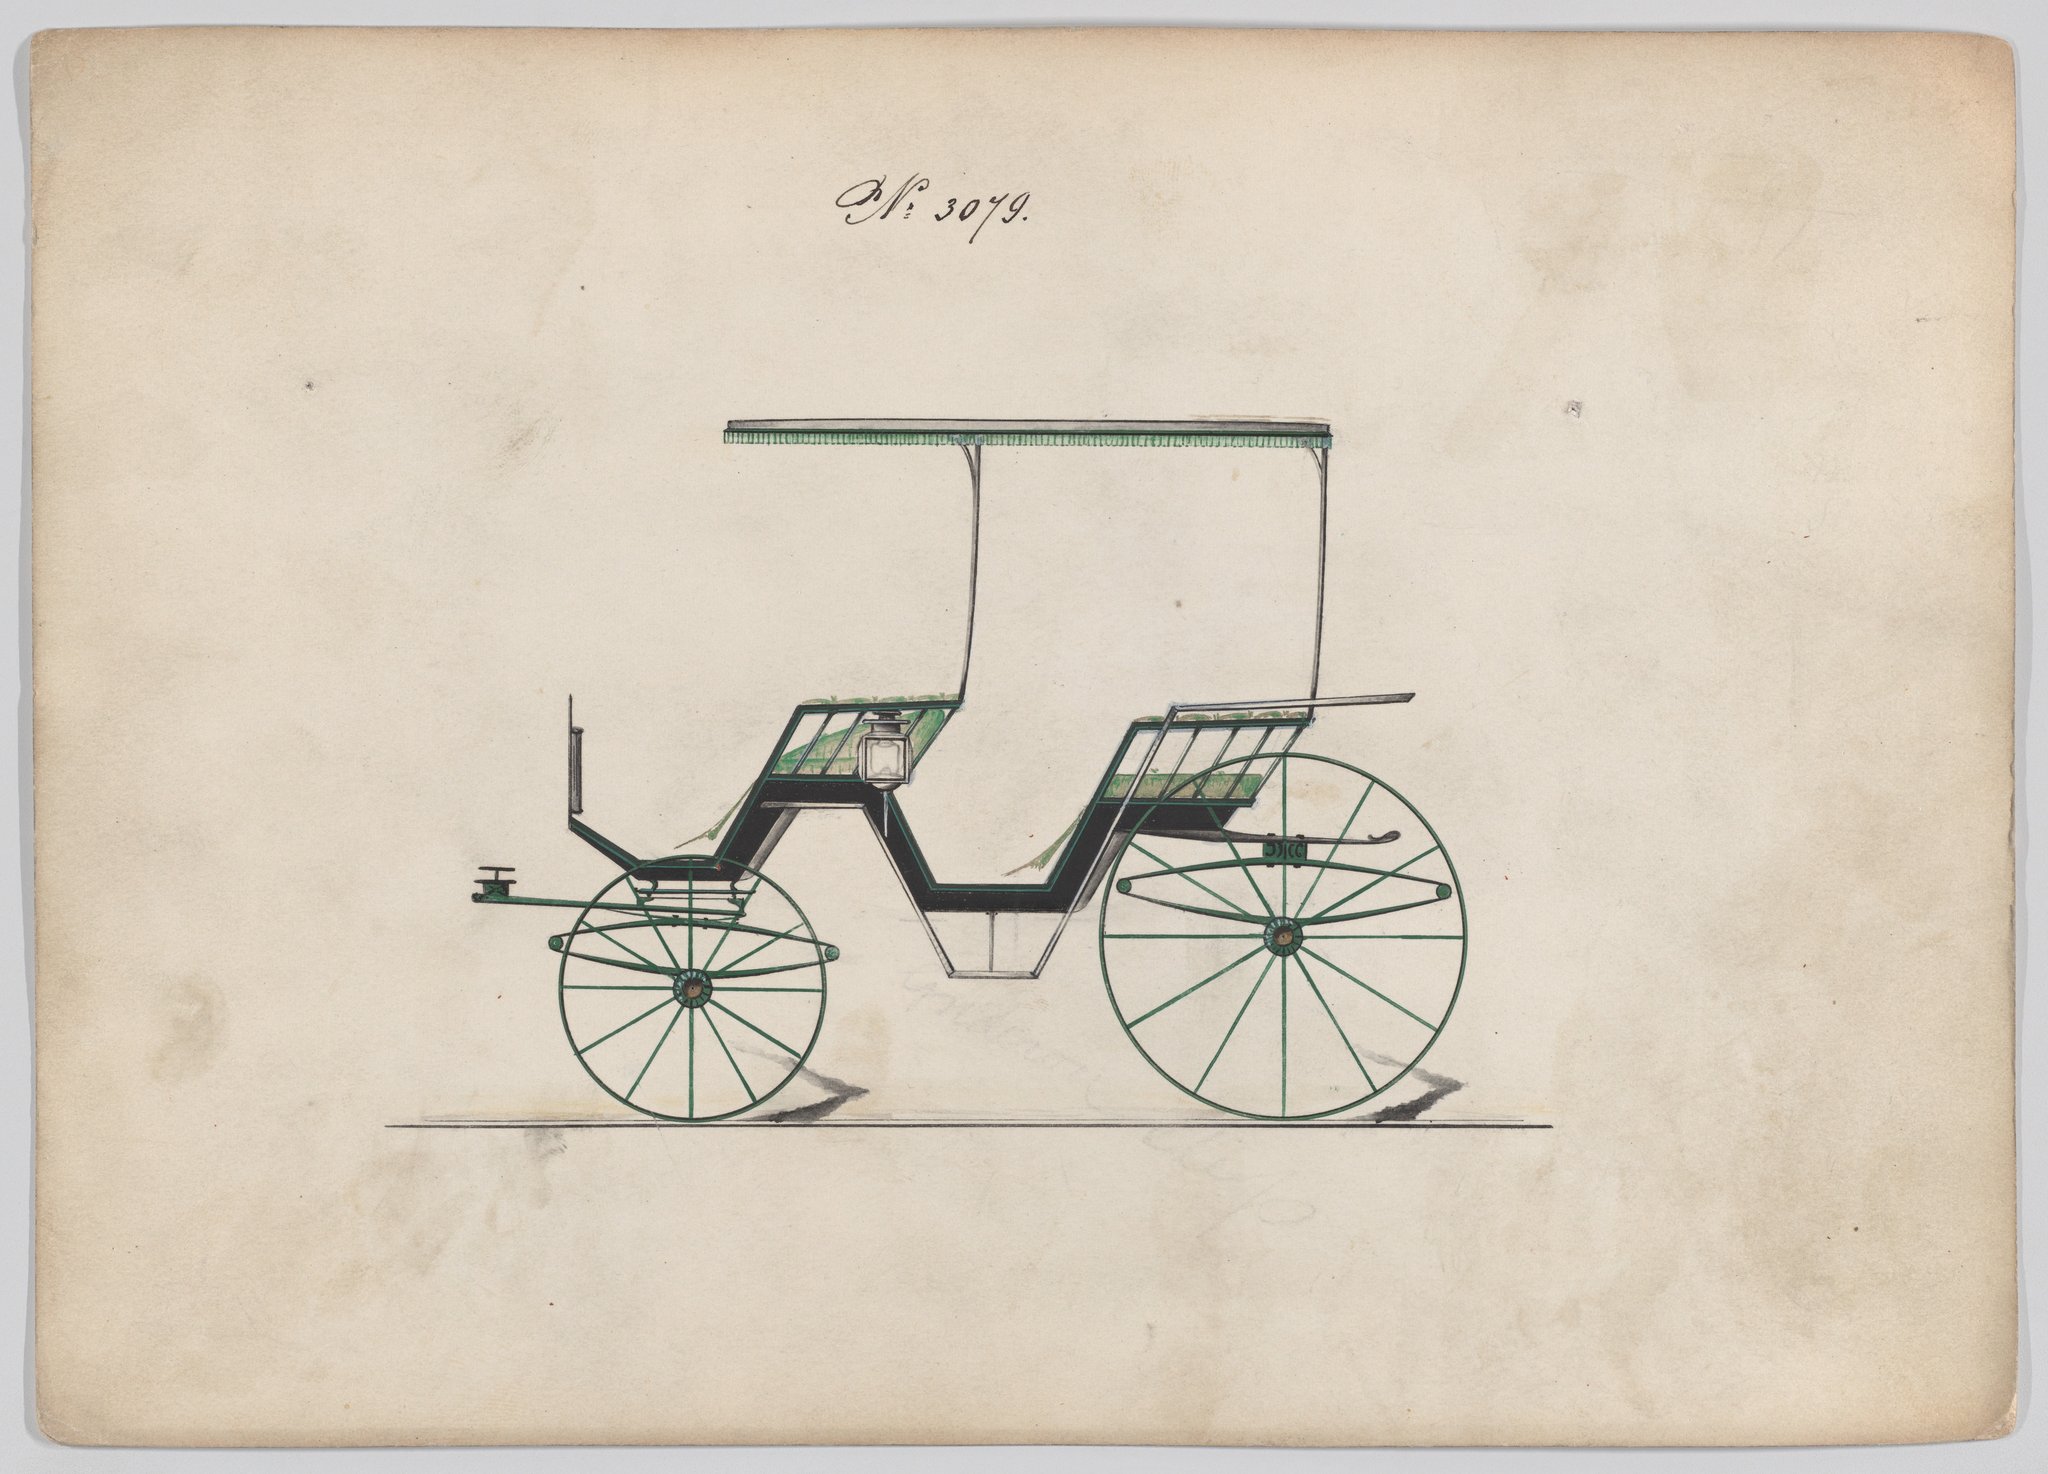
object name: drawing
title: Design for Canopy Top Phaeton, no. 3079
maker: brewster & co.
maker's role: manufacturer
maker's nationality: american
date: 1874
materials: gouache, ink, watercolor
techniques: pen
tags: carriages